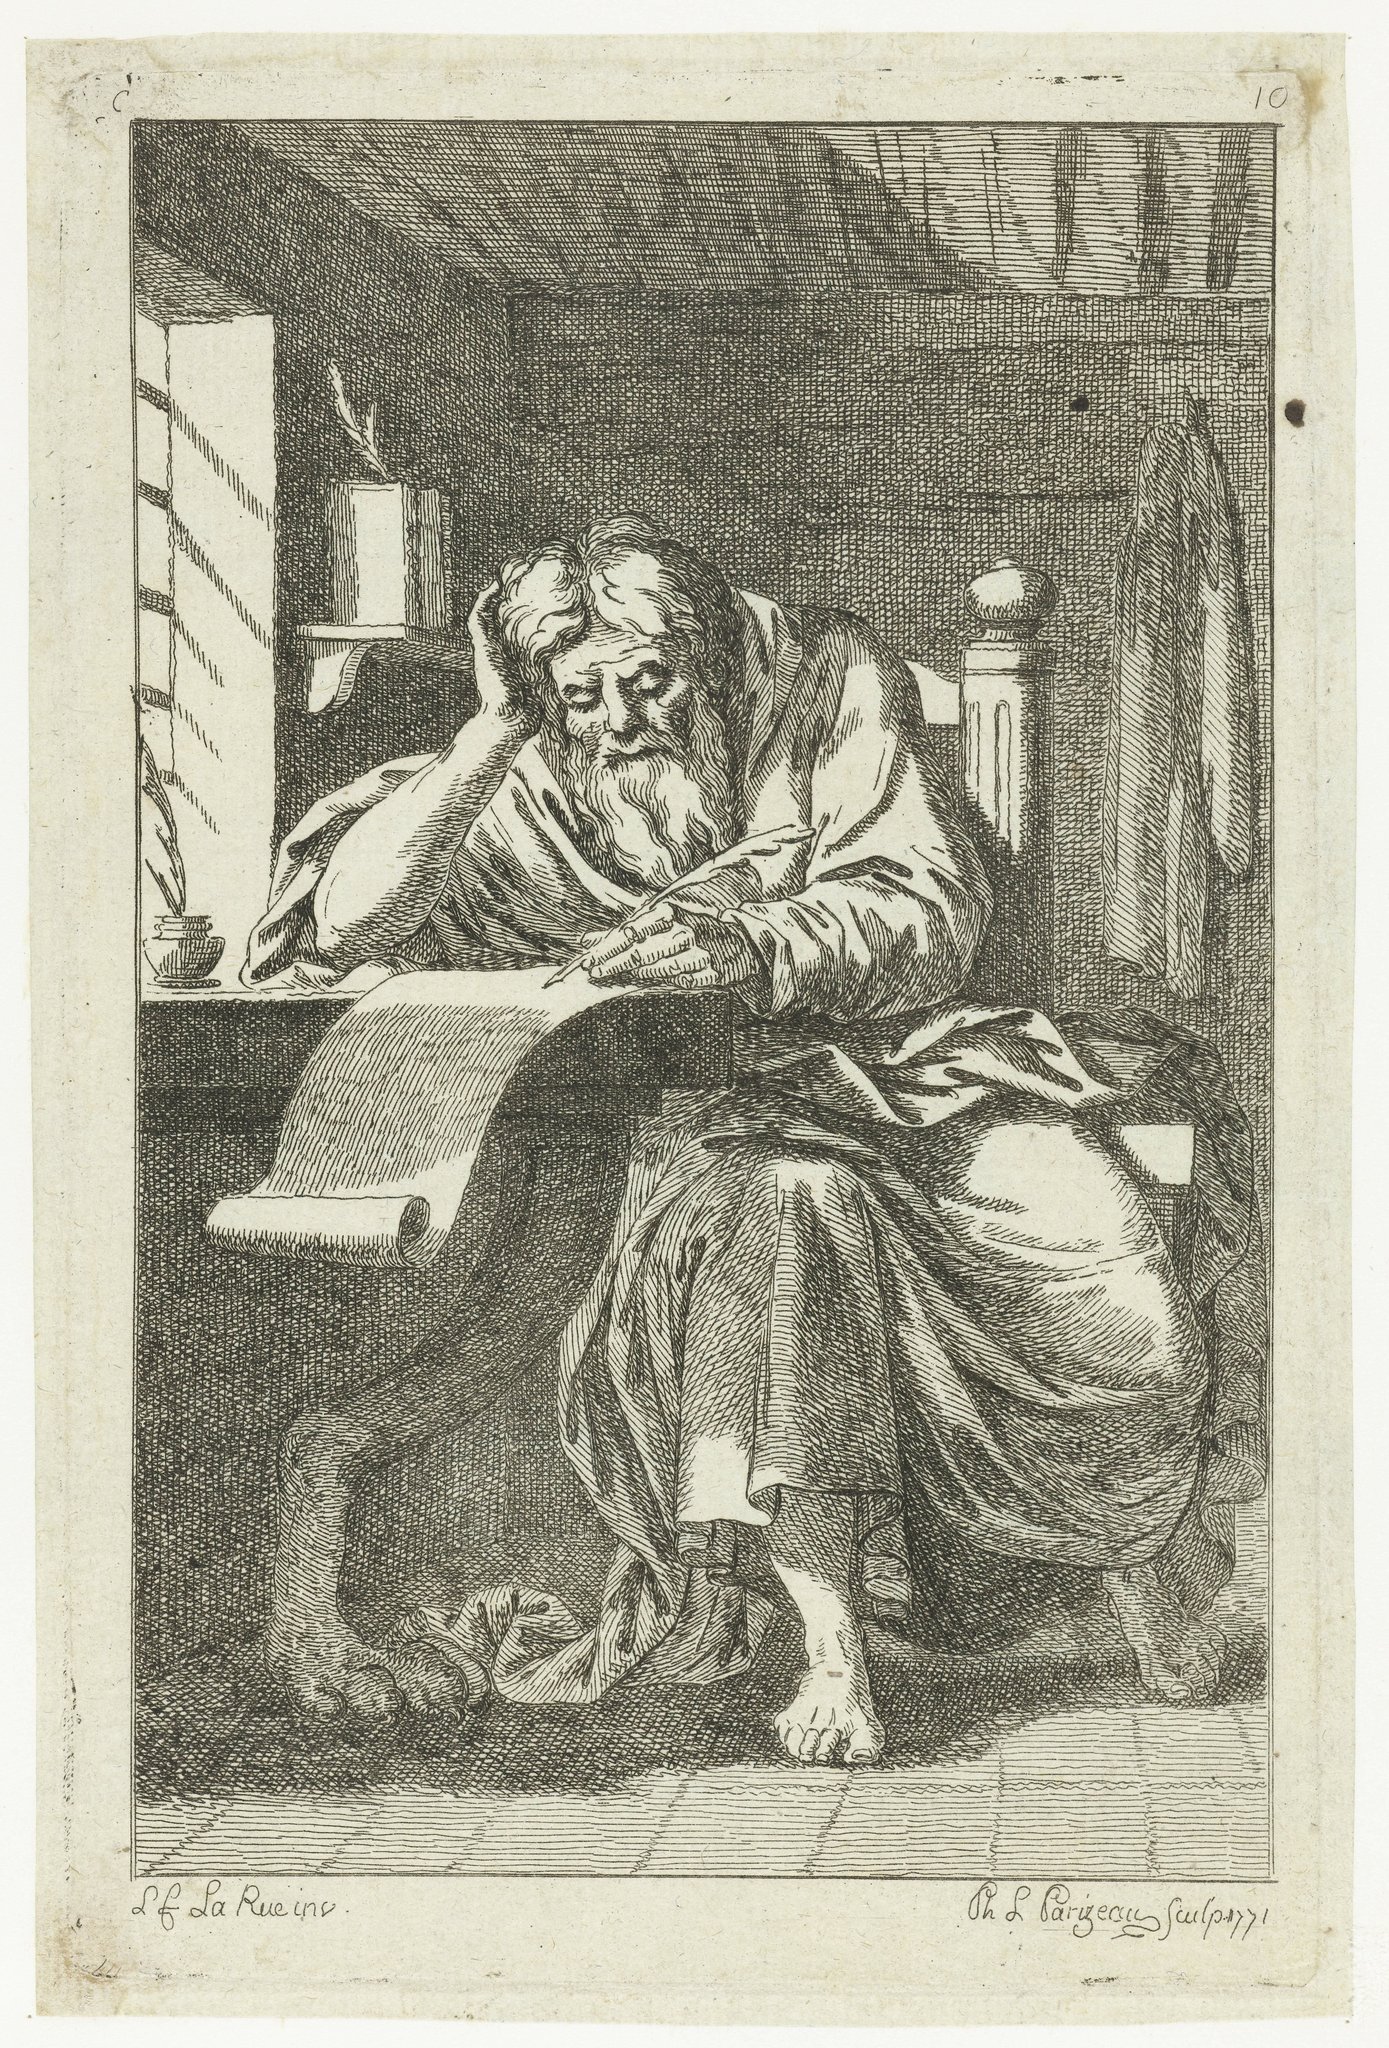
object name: print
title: Geleerde schrijvend in zijn studeervertrek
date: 1771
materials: paper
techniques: etching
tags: handwriting, writing as activity, scholar in his study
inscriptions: collector's mark: Lugt 2273, collector's mark: Lugt 2228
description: Een geleerde in zijn studeervertrek, zittend aan een tafel en schrijvend op een rol papier.